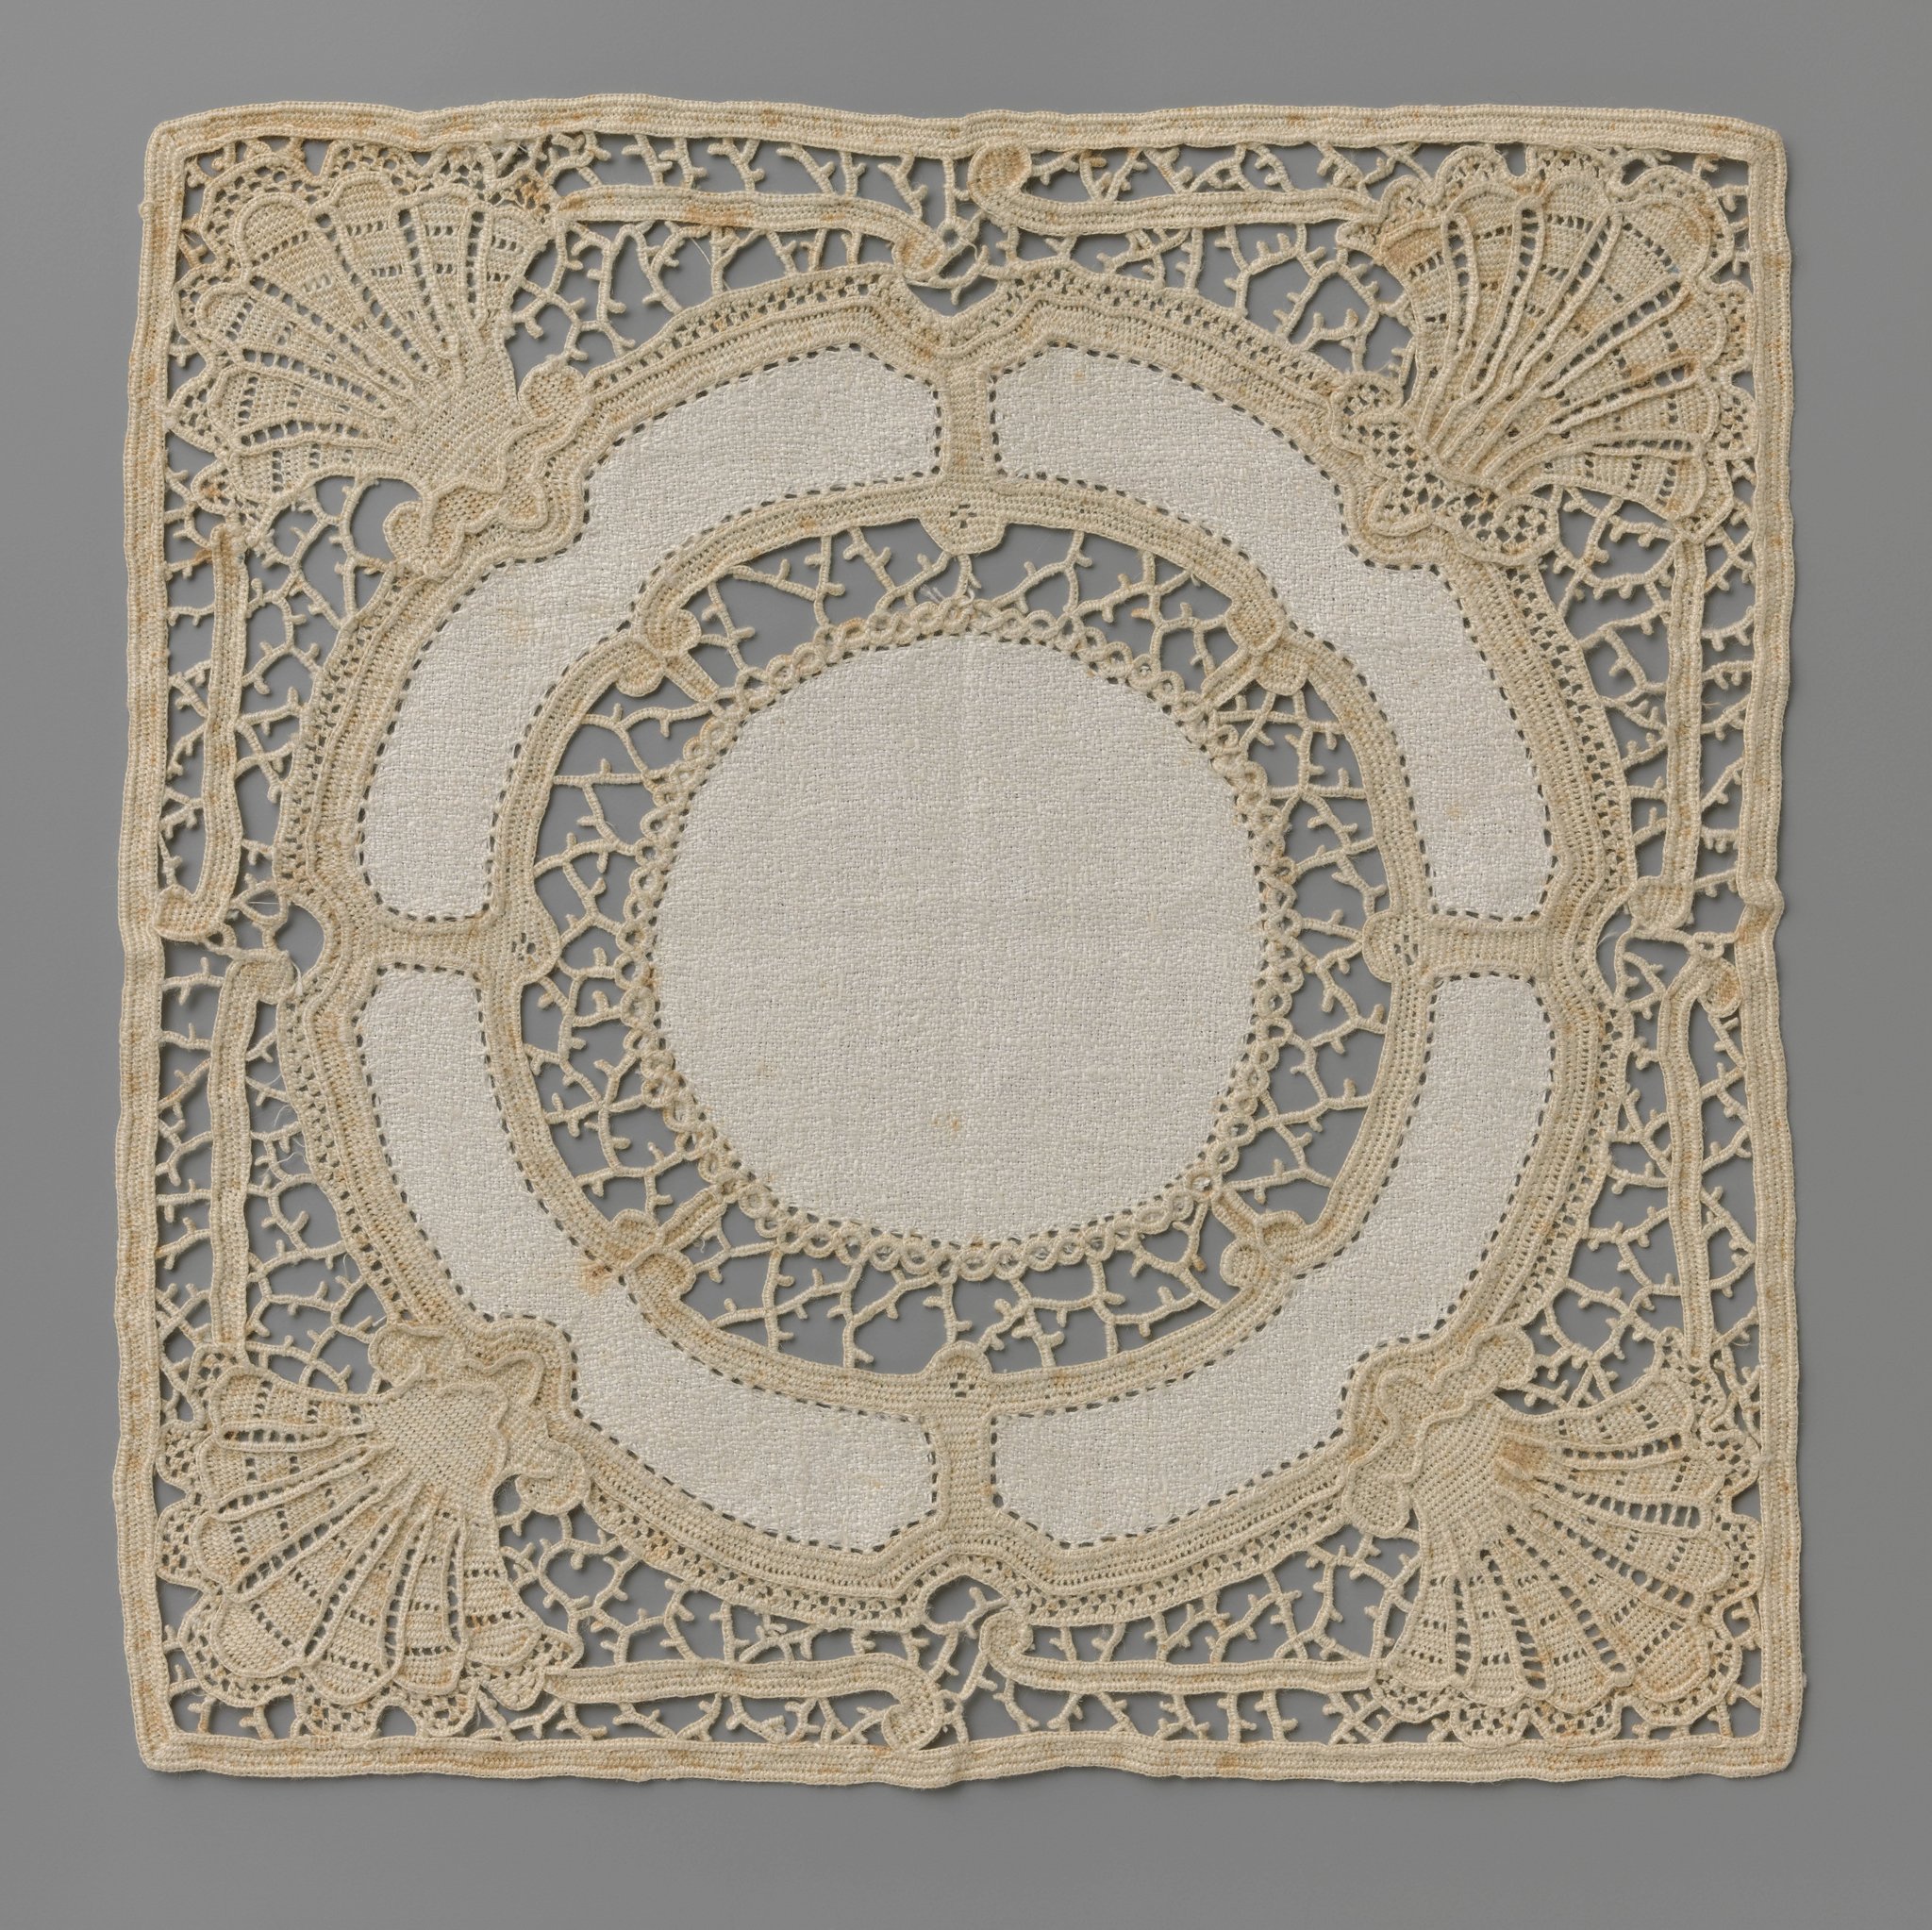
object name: kleed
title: Kleed van naaldkant met vier waaierpalmetten en een rond linnen middenstuk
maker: Anonymous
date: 1900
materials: linen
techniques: embroidery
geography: switzerland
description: Kleed van linnen en naturelkleurige naaldkant: Venetiaanse reliëfkant. Vierkant model met een rond linnen centrum en vier inzetstukken van linnen in de ring om het centrum heen. Patroon met gepicoteerde spijlen en in elke hoek een waaierpalmet.